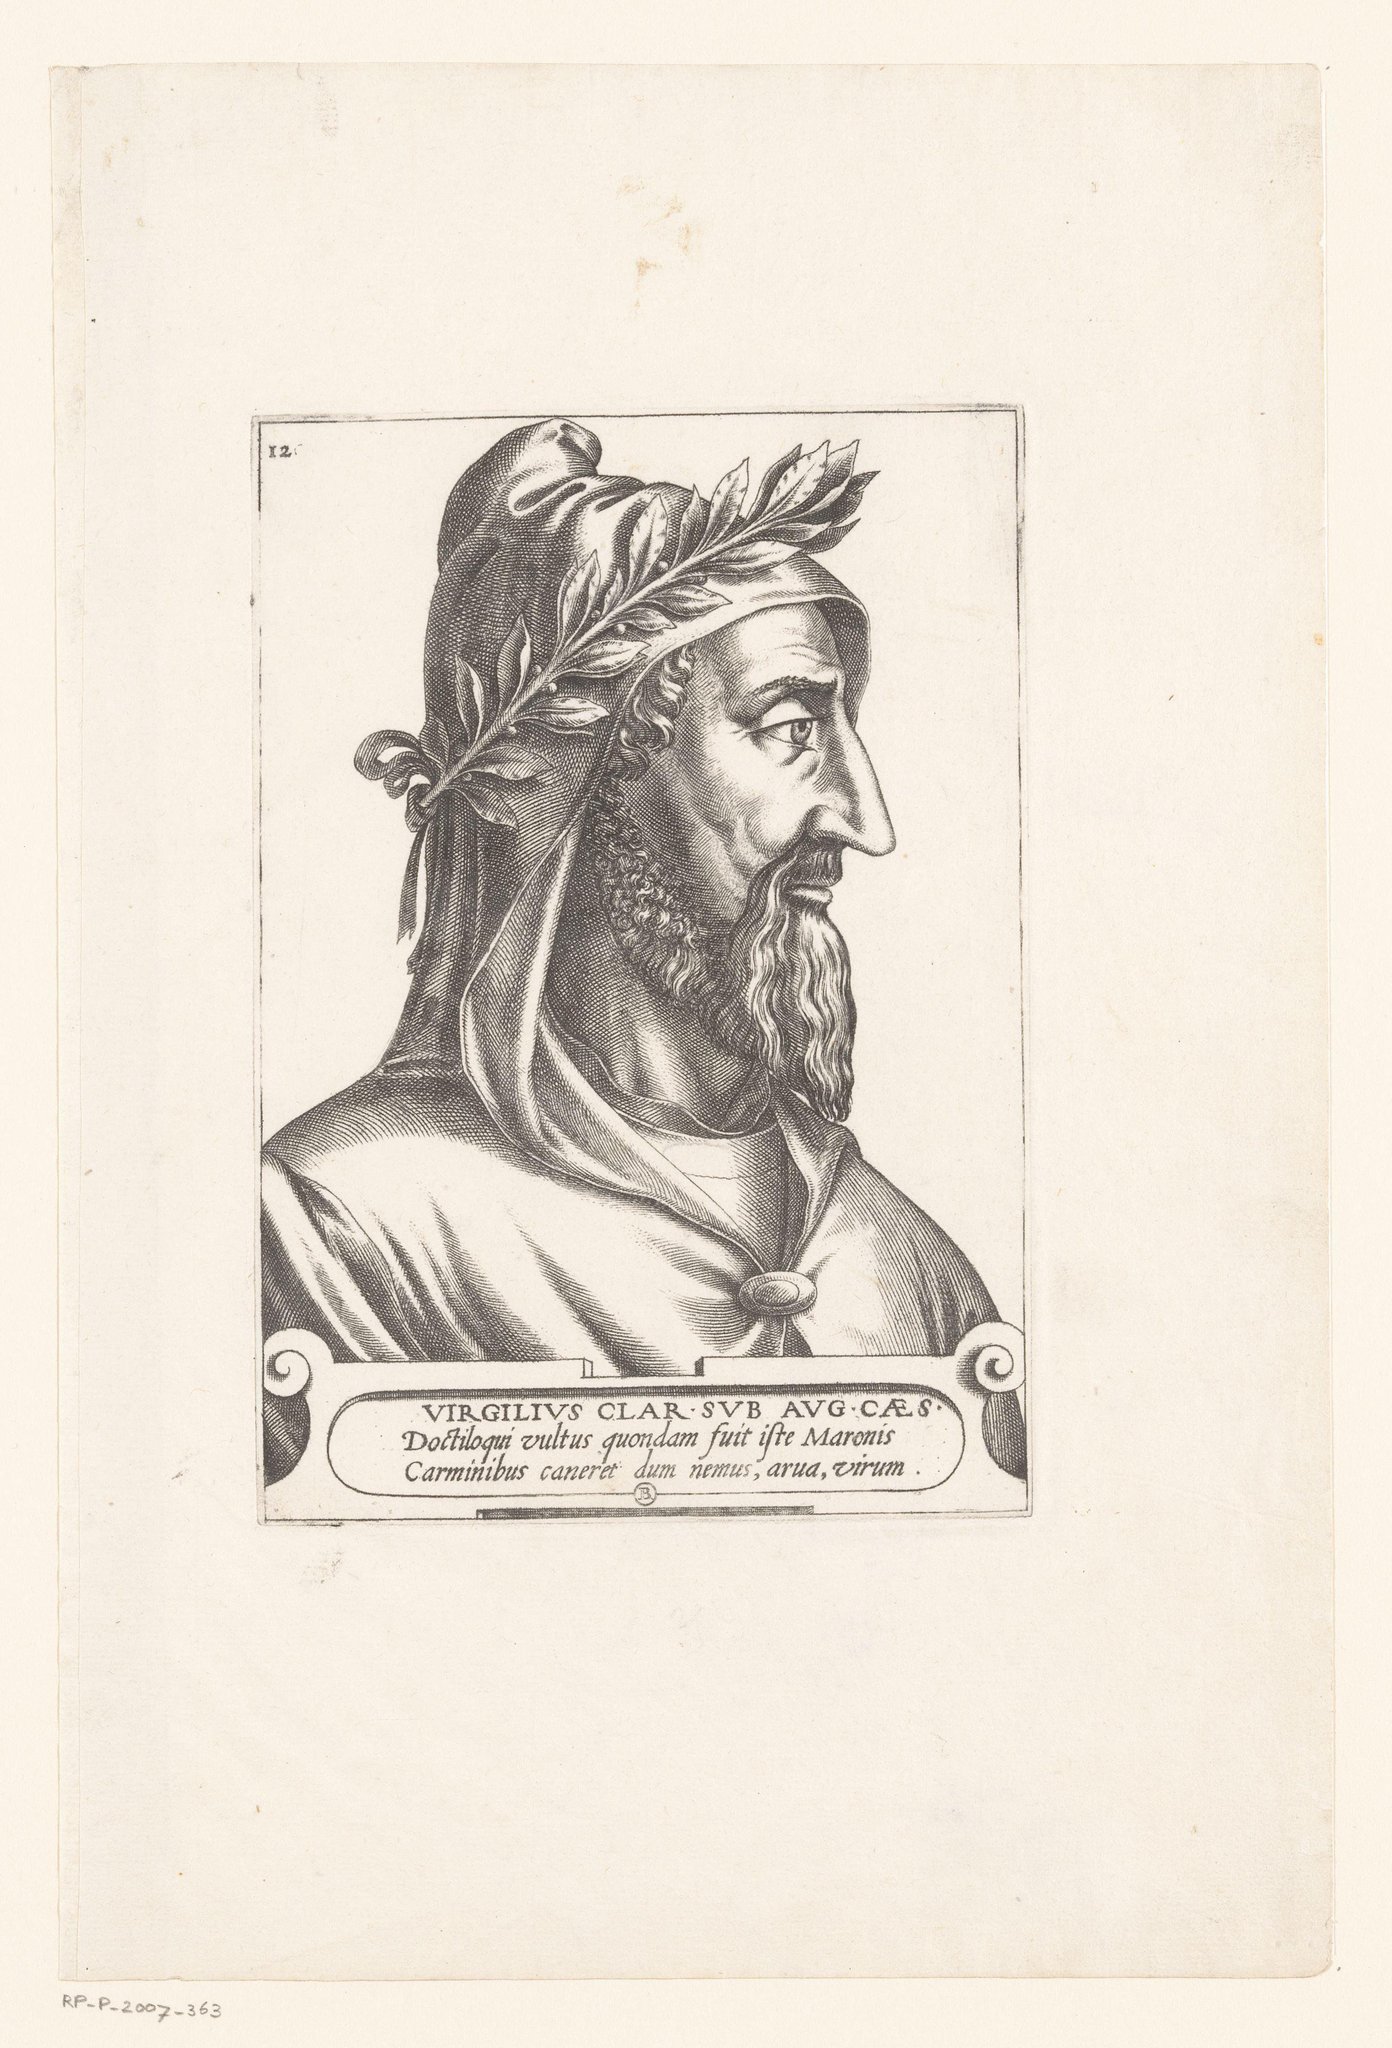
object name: print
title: Illustrium philosophorum et poetarum effigies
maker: rené boyvin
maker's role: print maker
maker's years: 1525-1598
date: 1566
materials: paper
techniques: engraving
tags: publius vergilius maro, the poet virgilius, historical persons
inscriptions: collector's mark: Lugt 2228, collector's mark: Lugt 2760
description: Maakt deel uit van een serie van twaalf portretten van Griekse en Romeinse filosofen, getiteld 'Illustrium philosophorum et poetarum effigies', uitgegeven in 1566 door P. de Roville in Parijs.